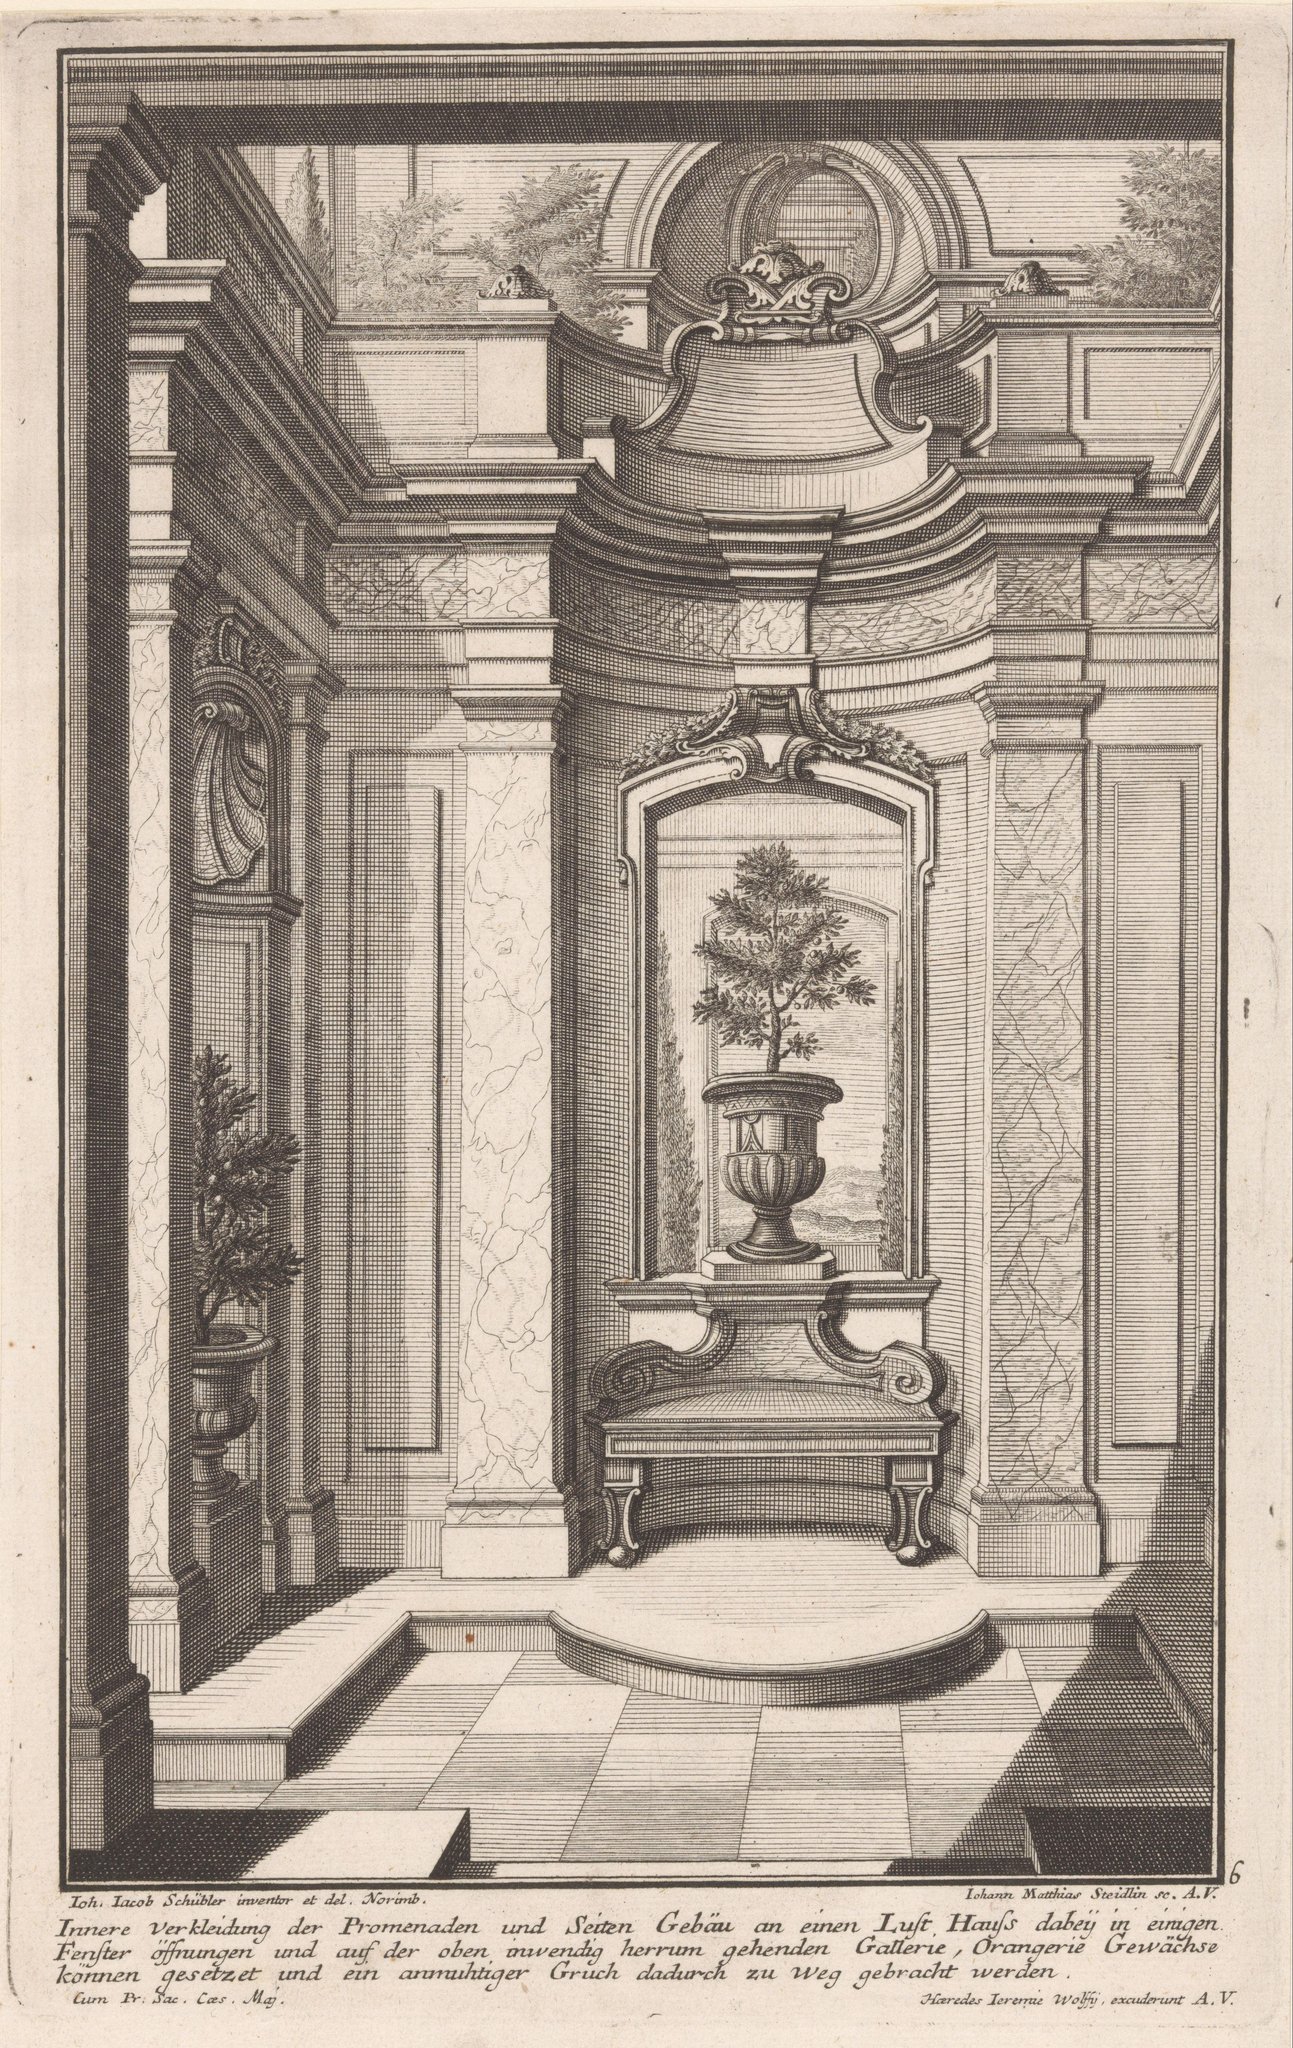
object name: ornament print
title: Johann Jacob Schüblers Siebende Ausgabe seines vorhabenden Wercks, Worinnen vorgestellet werden Neu-inventierte Sommer-Häuser, Garten-Cabinetten (...)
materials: paper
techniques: engraving, etching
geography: augsburg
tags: bench, plants; vegetation, summer-house, arbour, garden-house (dutch: 'theekoepel'), interior of the house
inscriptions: collector's mark: Lugt 2228, collector's mark: Lugt 2760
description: Interieur van een tuinhuis met bank en planten en kleine bomen in een nis, een venster en bovenop de galerij. In de ondermarge een drieregelige Duitse tekst.